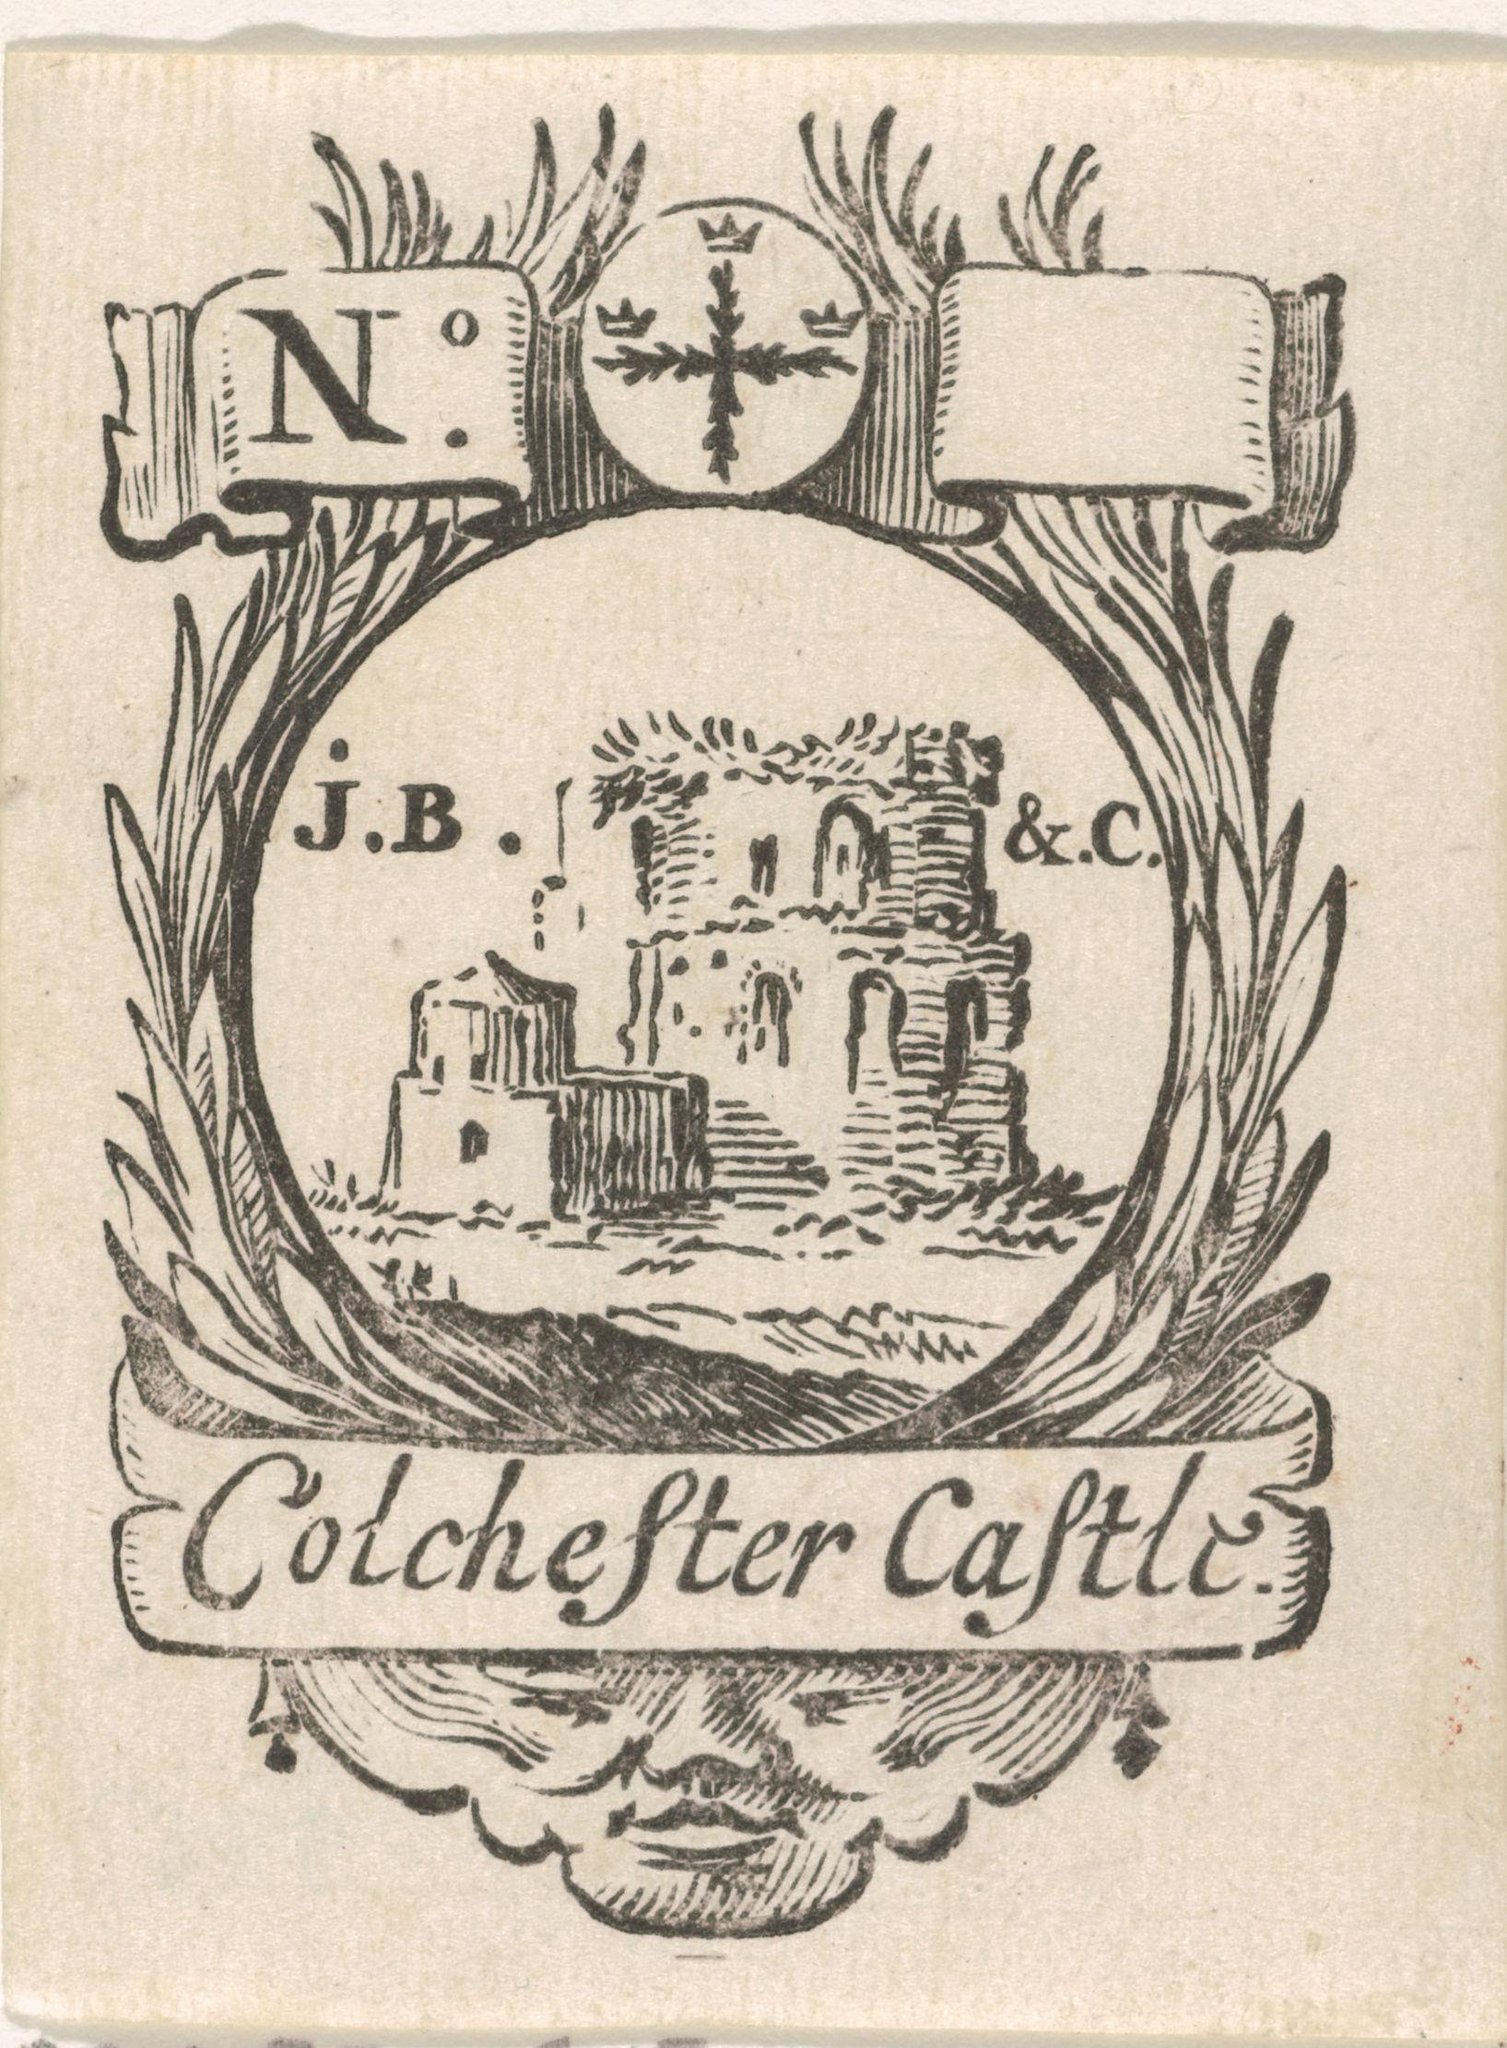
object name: handelsetiket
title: Colchester Castle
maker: isaac vincentsz. van der vinne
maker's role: draughtsman, print maker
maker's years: 1665-1740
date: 1681-1740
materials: paper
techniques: woodcut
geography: haarlem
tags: vignette, ruin of a dwelling, house, castle, etc.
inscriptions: collector's mark: Lugt 240